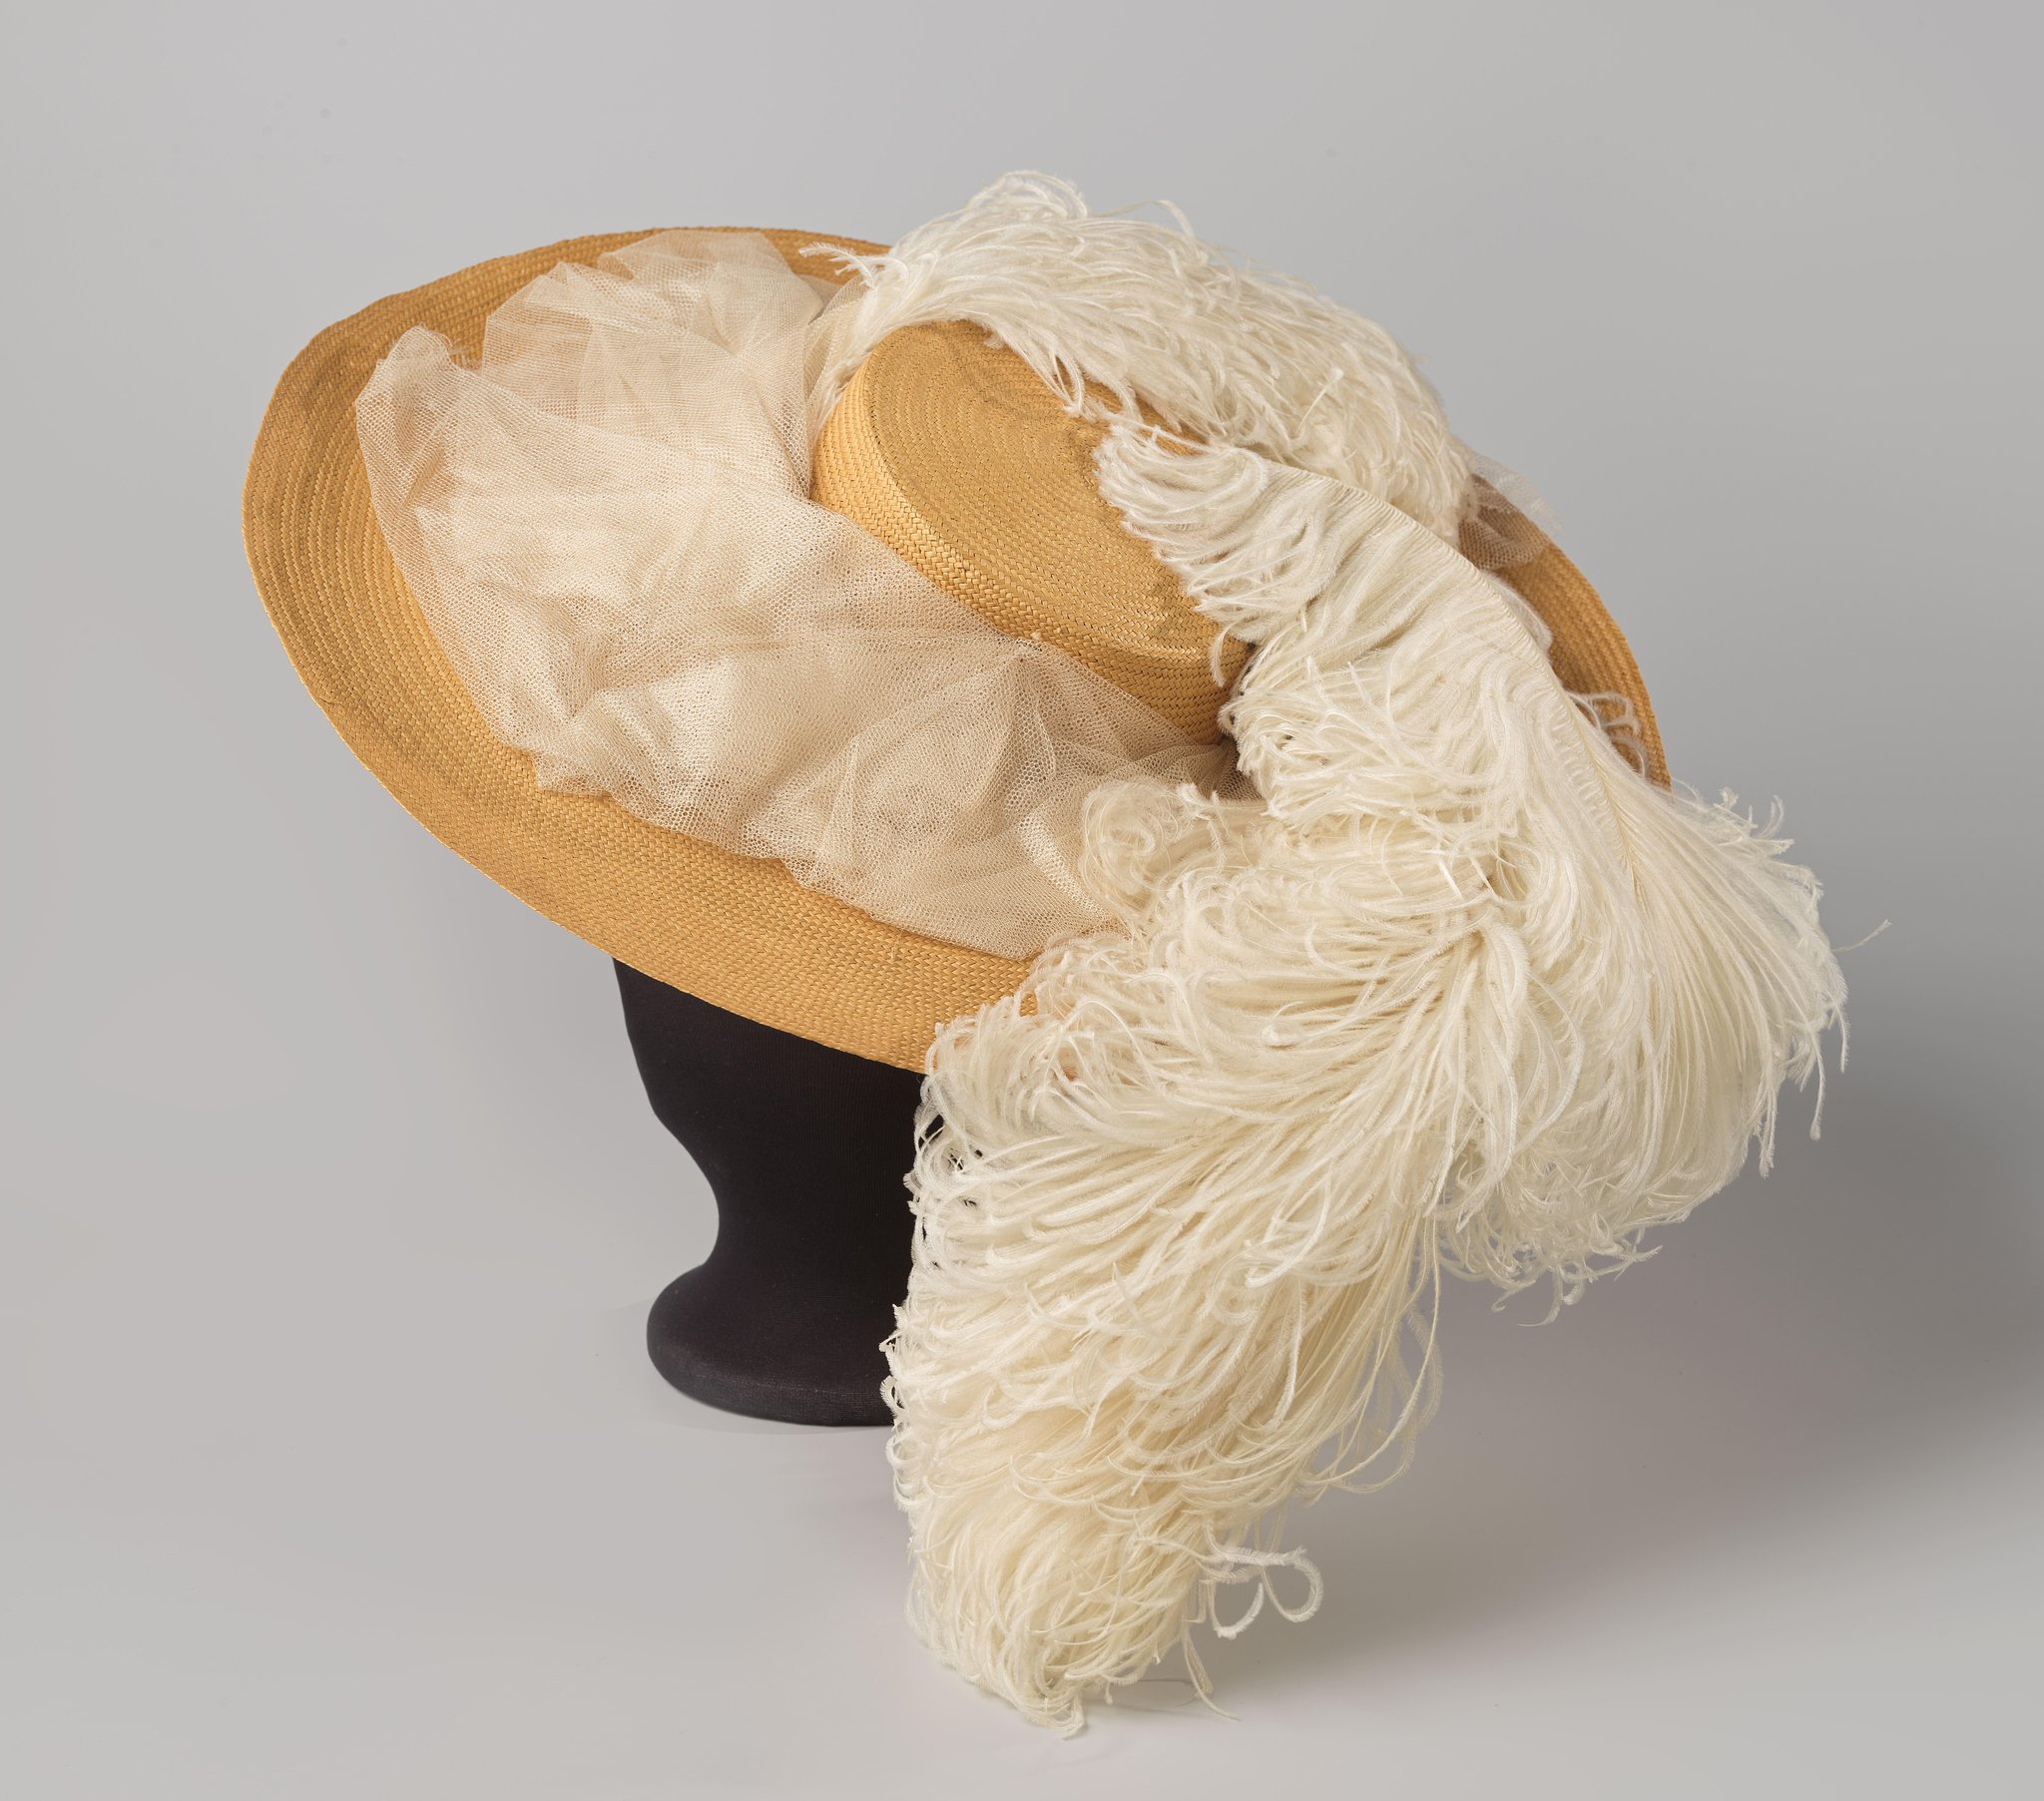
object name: hat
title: Hoed naturelkleurig stro, platte bol en brede rand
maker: rosa goutureau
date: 1903-1910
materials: silk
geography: france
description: Hoed van Italiaans stro, platte bol en brede rand. Versierd met zijden tule, twee champagne-kleurige struisveren en één witte, 'pleureuses'. Adres: Mme Rosa Goutureau / Modes de Paris / Rue du Casino 15 / Vichy.